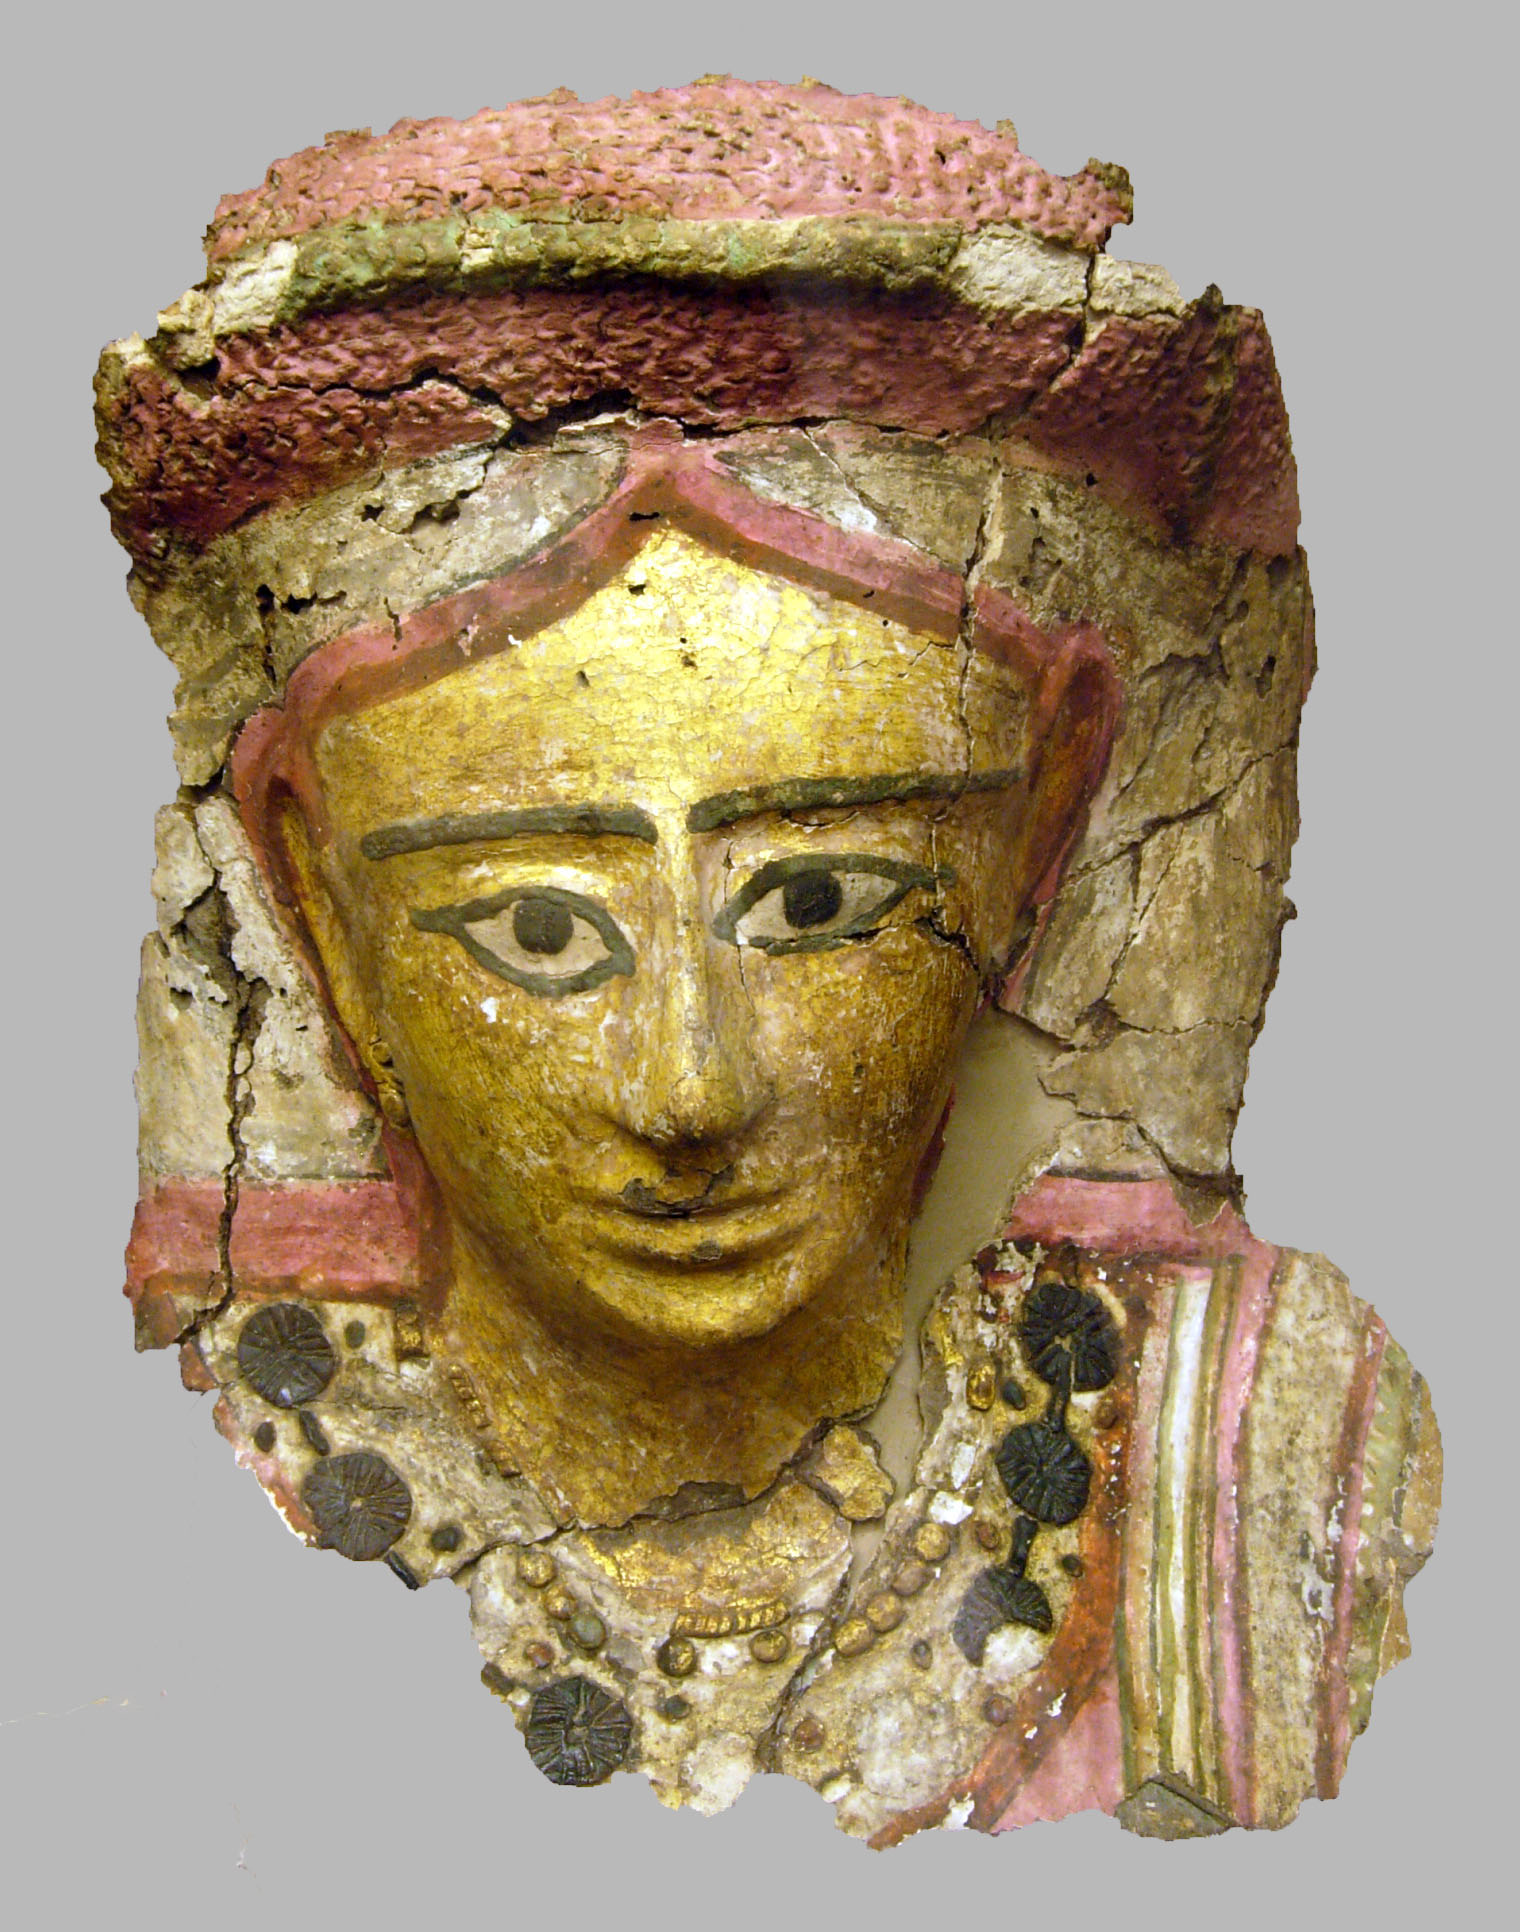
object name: mask of a woman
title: Funerary Mask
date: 50 BCE-50 CE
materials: gesso, mud, paint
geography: egypt